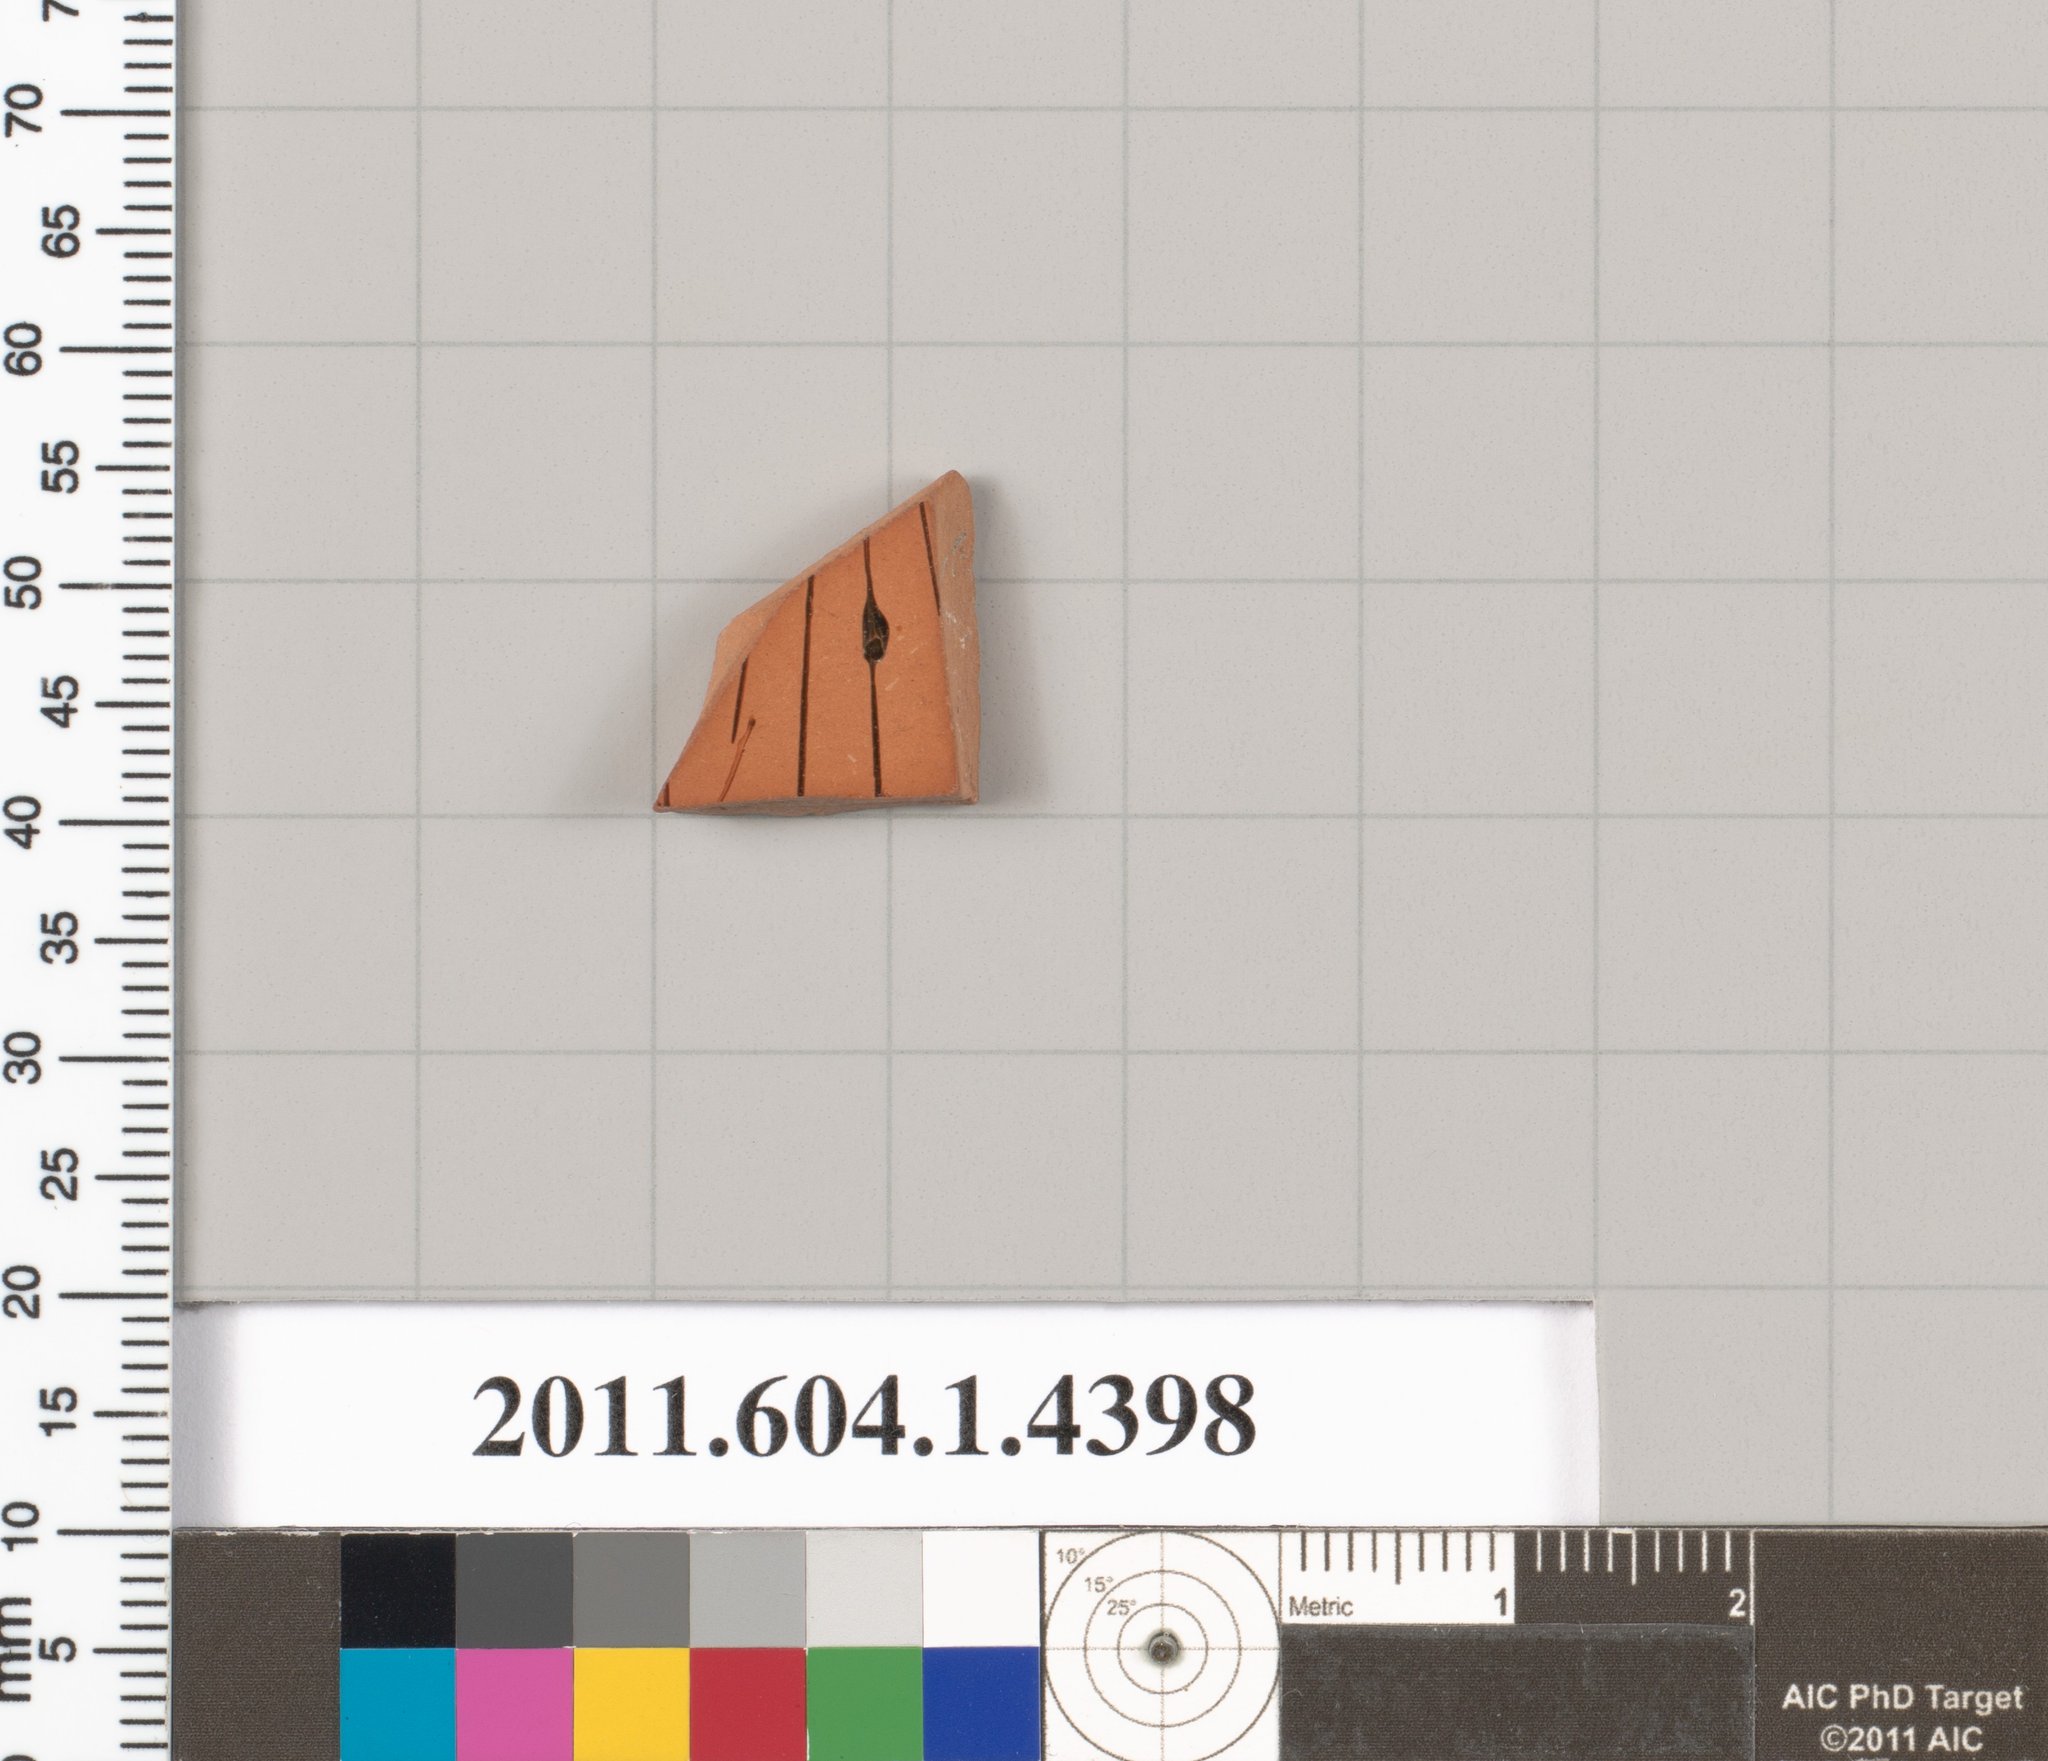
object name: kylix fragment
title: Terracotta fragment of a kylix (drinking cup)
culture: greek, attic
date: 475-451 BCE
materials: terracotta